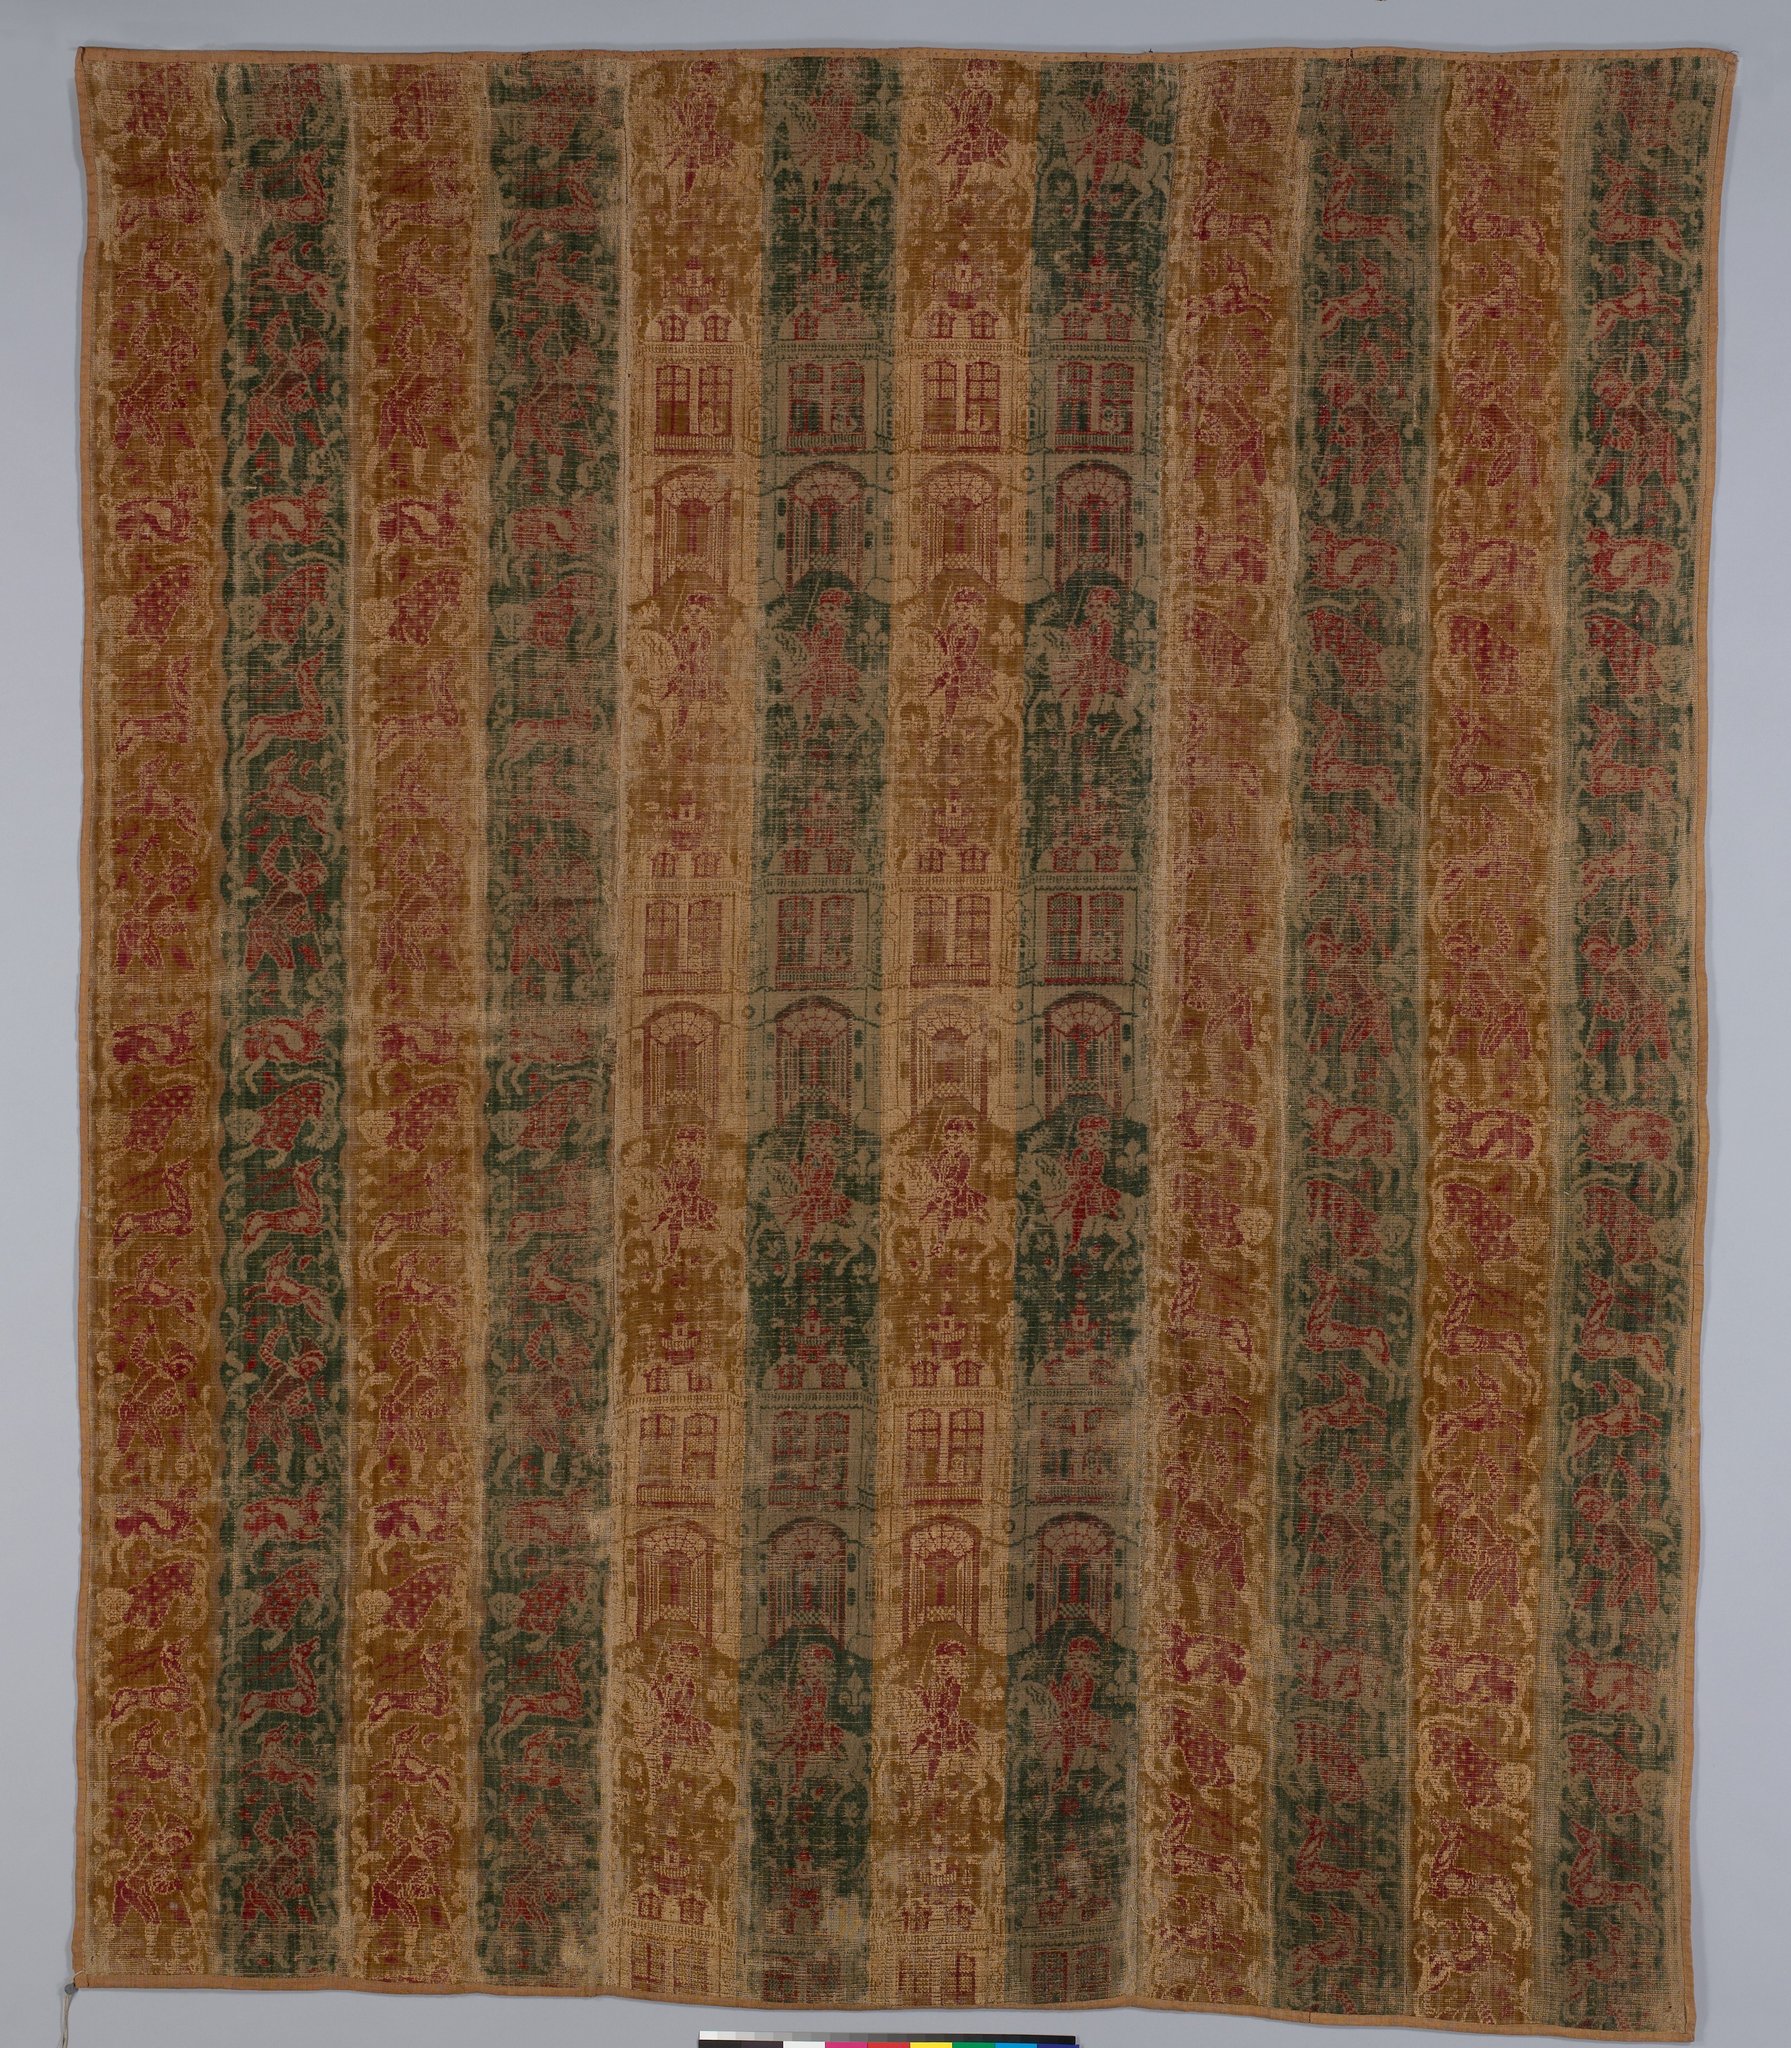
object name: hanging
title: Hanging of wool velvet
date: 1667-1700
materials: linen, wool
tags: animals,buildings,men,horses